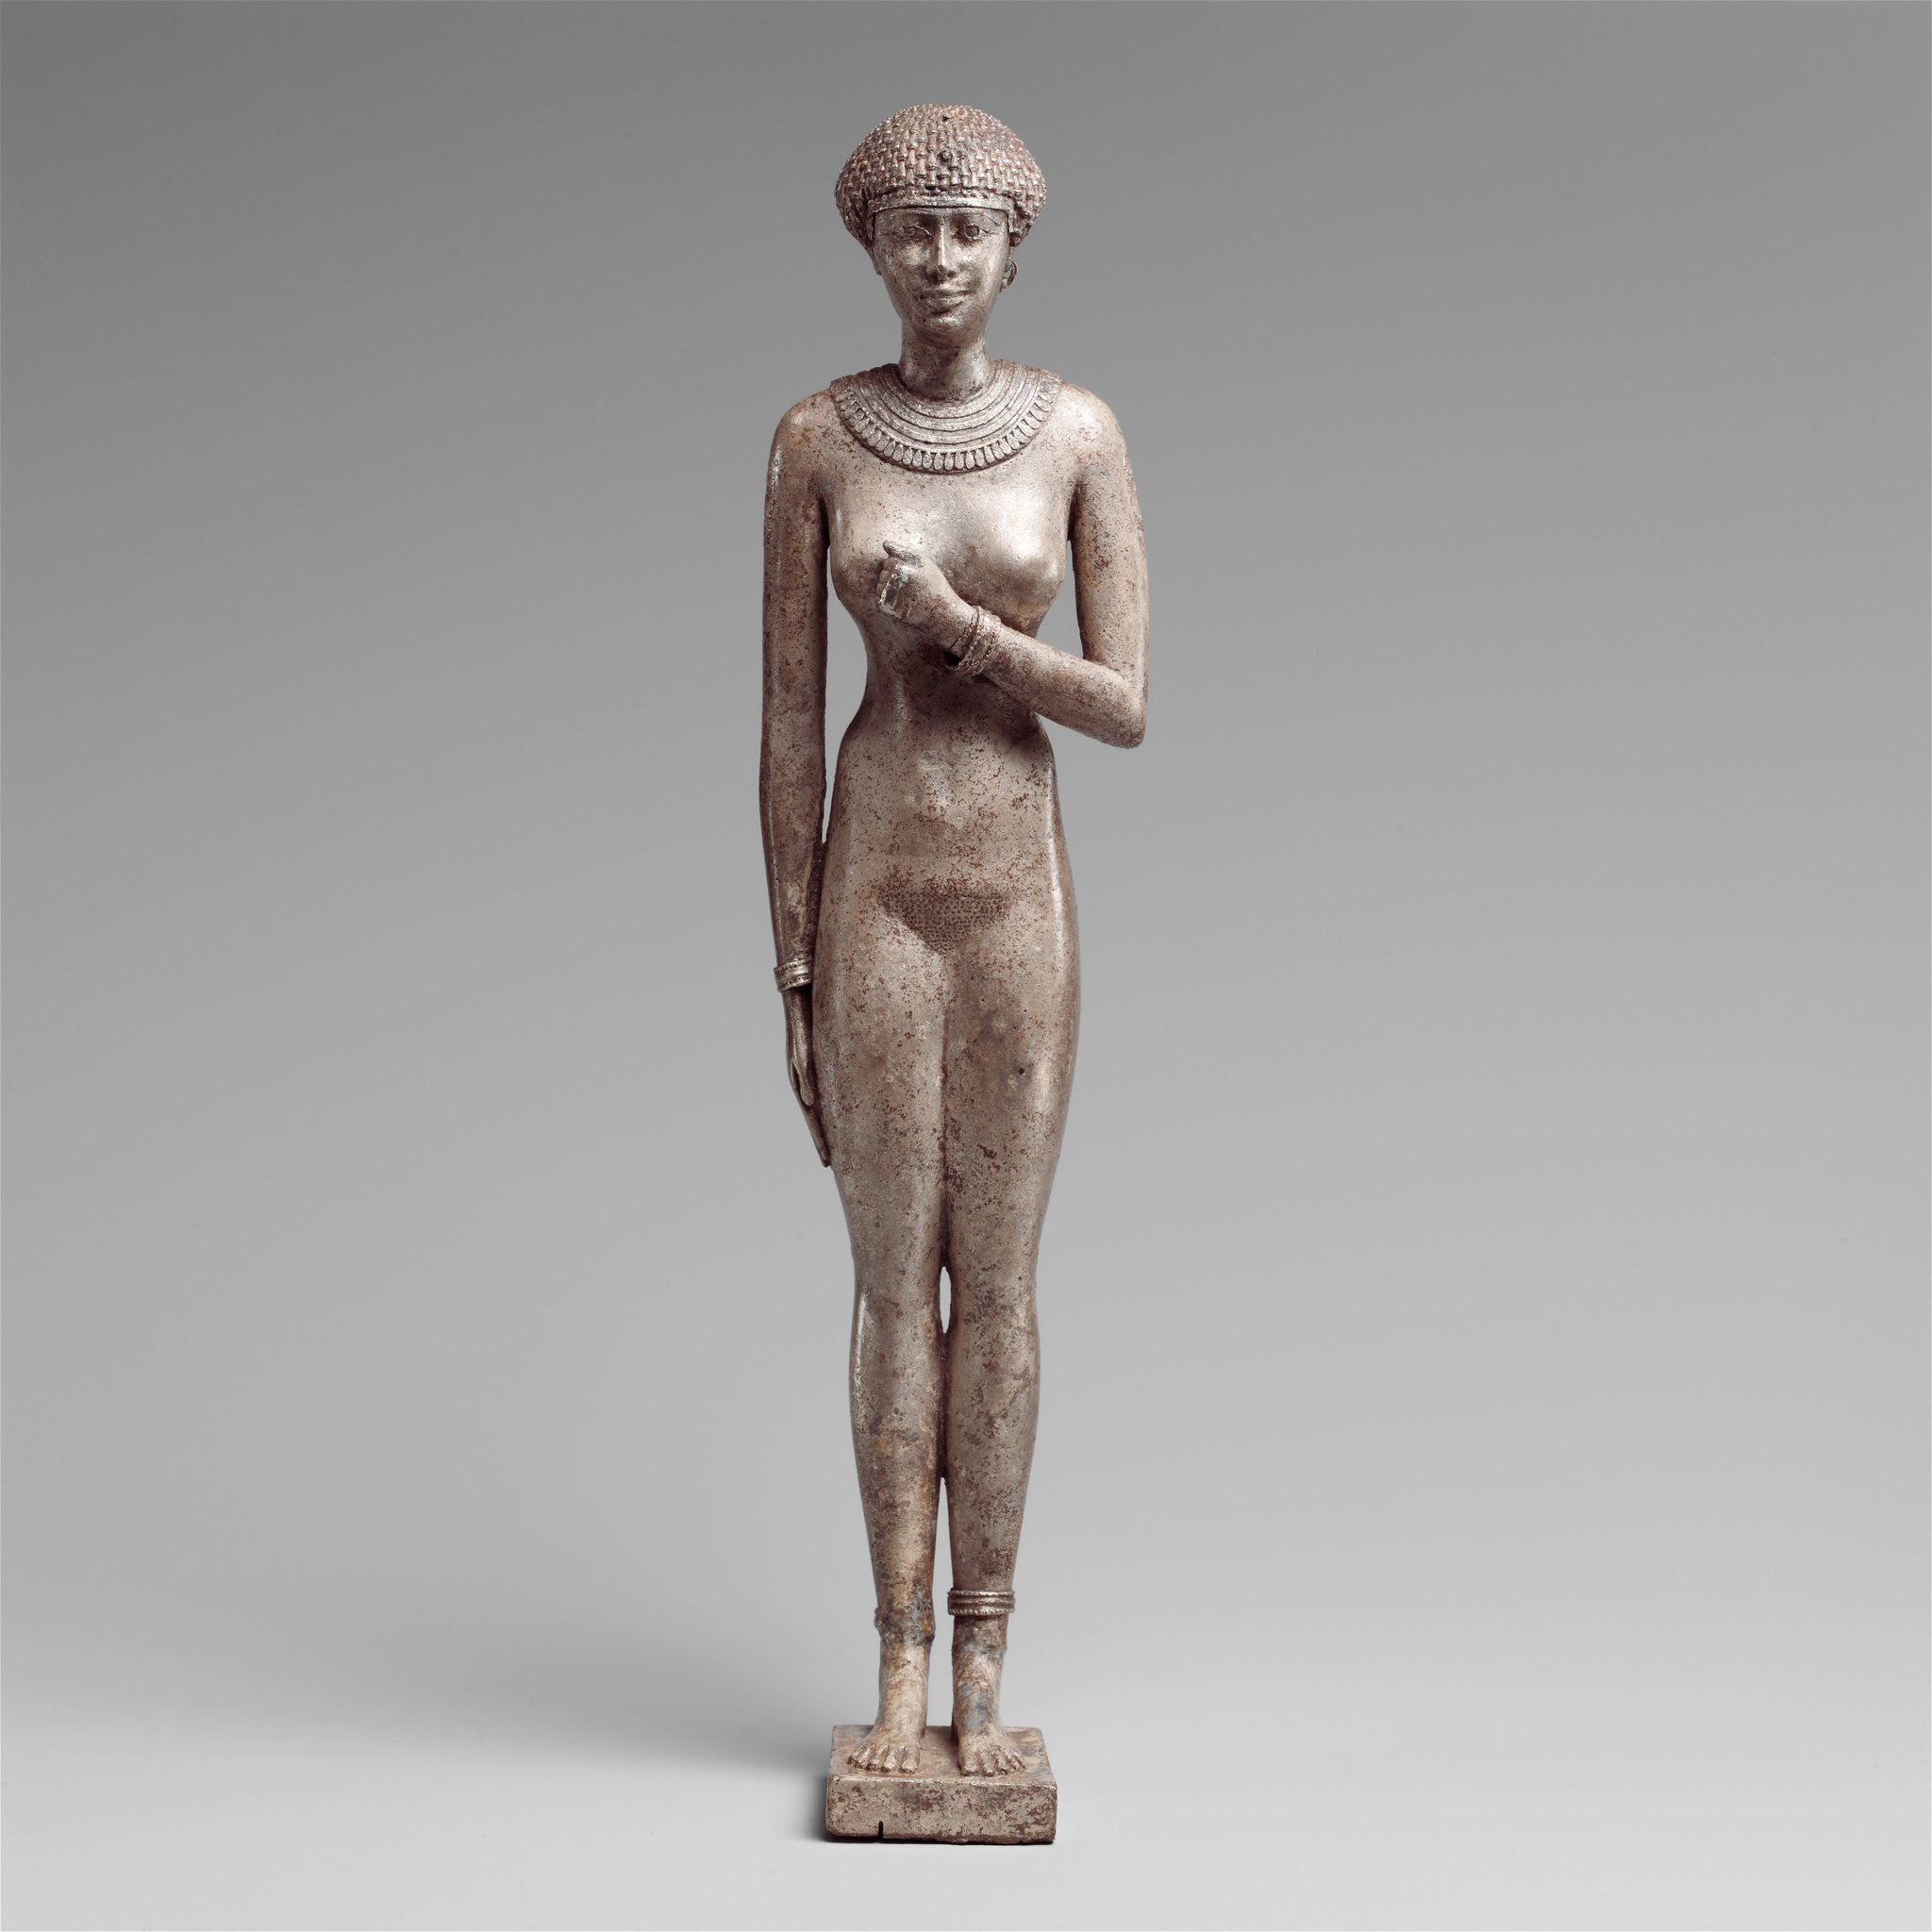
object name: female statuette with cartouch of necho ii on her arm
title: Statuette of a Royal (?) Woman with the Cartouches of Necho II on her Arms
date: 610-595 BCE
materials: silver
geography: egypt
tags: cartouches,female nudes